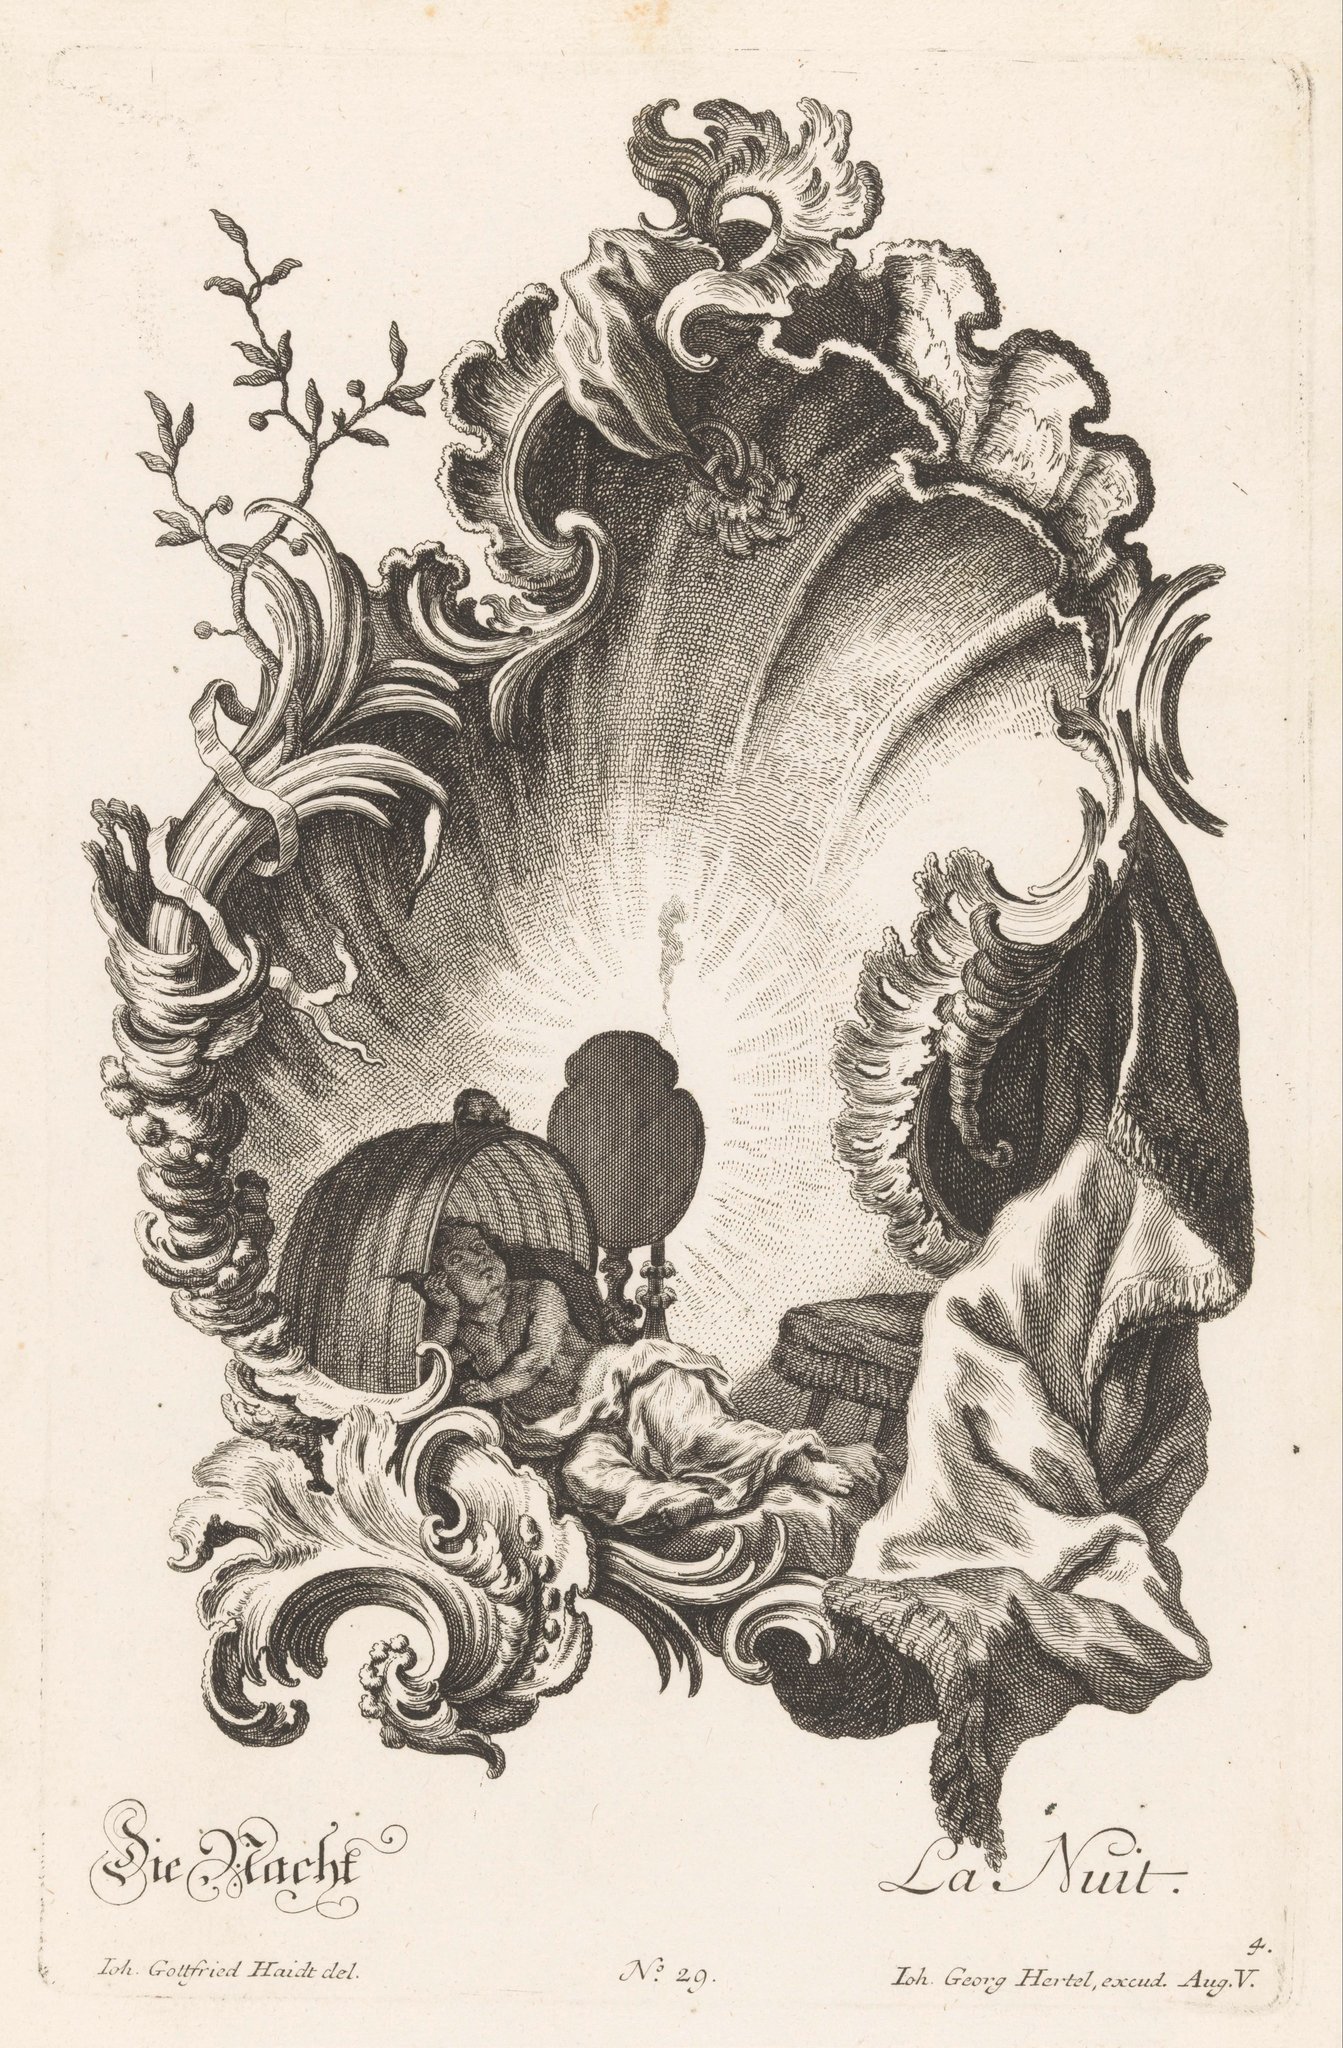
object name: print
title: Die Nacht / La Nuit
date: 1745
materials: paper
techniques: etching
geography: augsburg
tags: personification of the night, 'nox'; 'notte', 'carro della notte', 'serenità della notte' (ripa), cupids: 'amores', 'amoretti', 'putti'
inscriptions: collector's mark: Lugt 2760, collector's mark: Lugt 2228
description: Personificatie van de nacht in een rocaille cartouche. Een putto slaapt in bed. Uitgeversnummer 29.